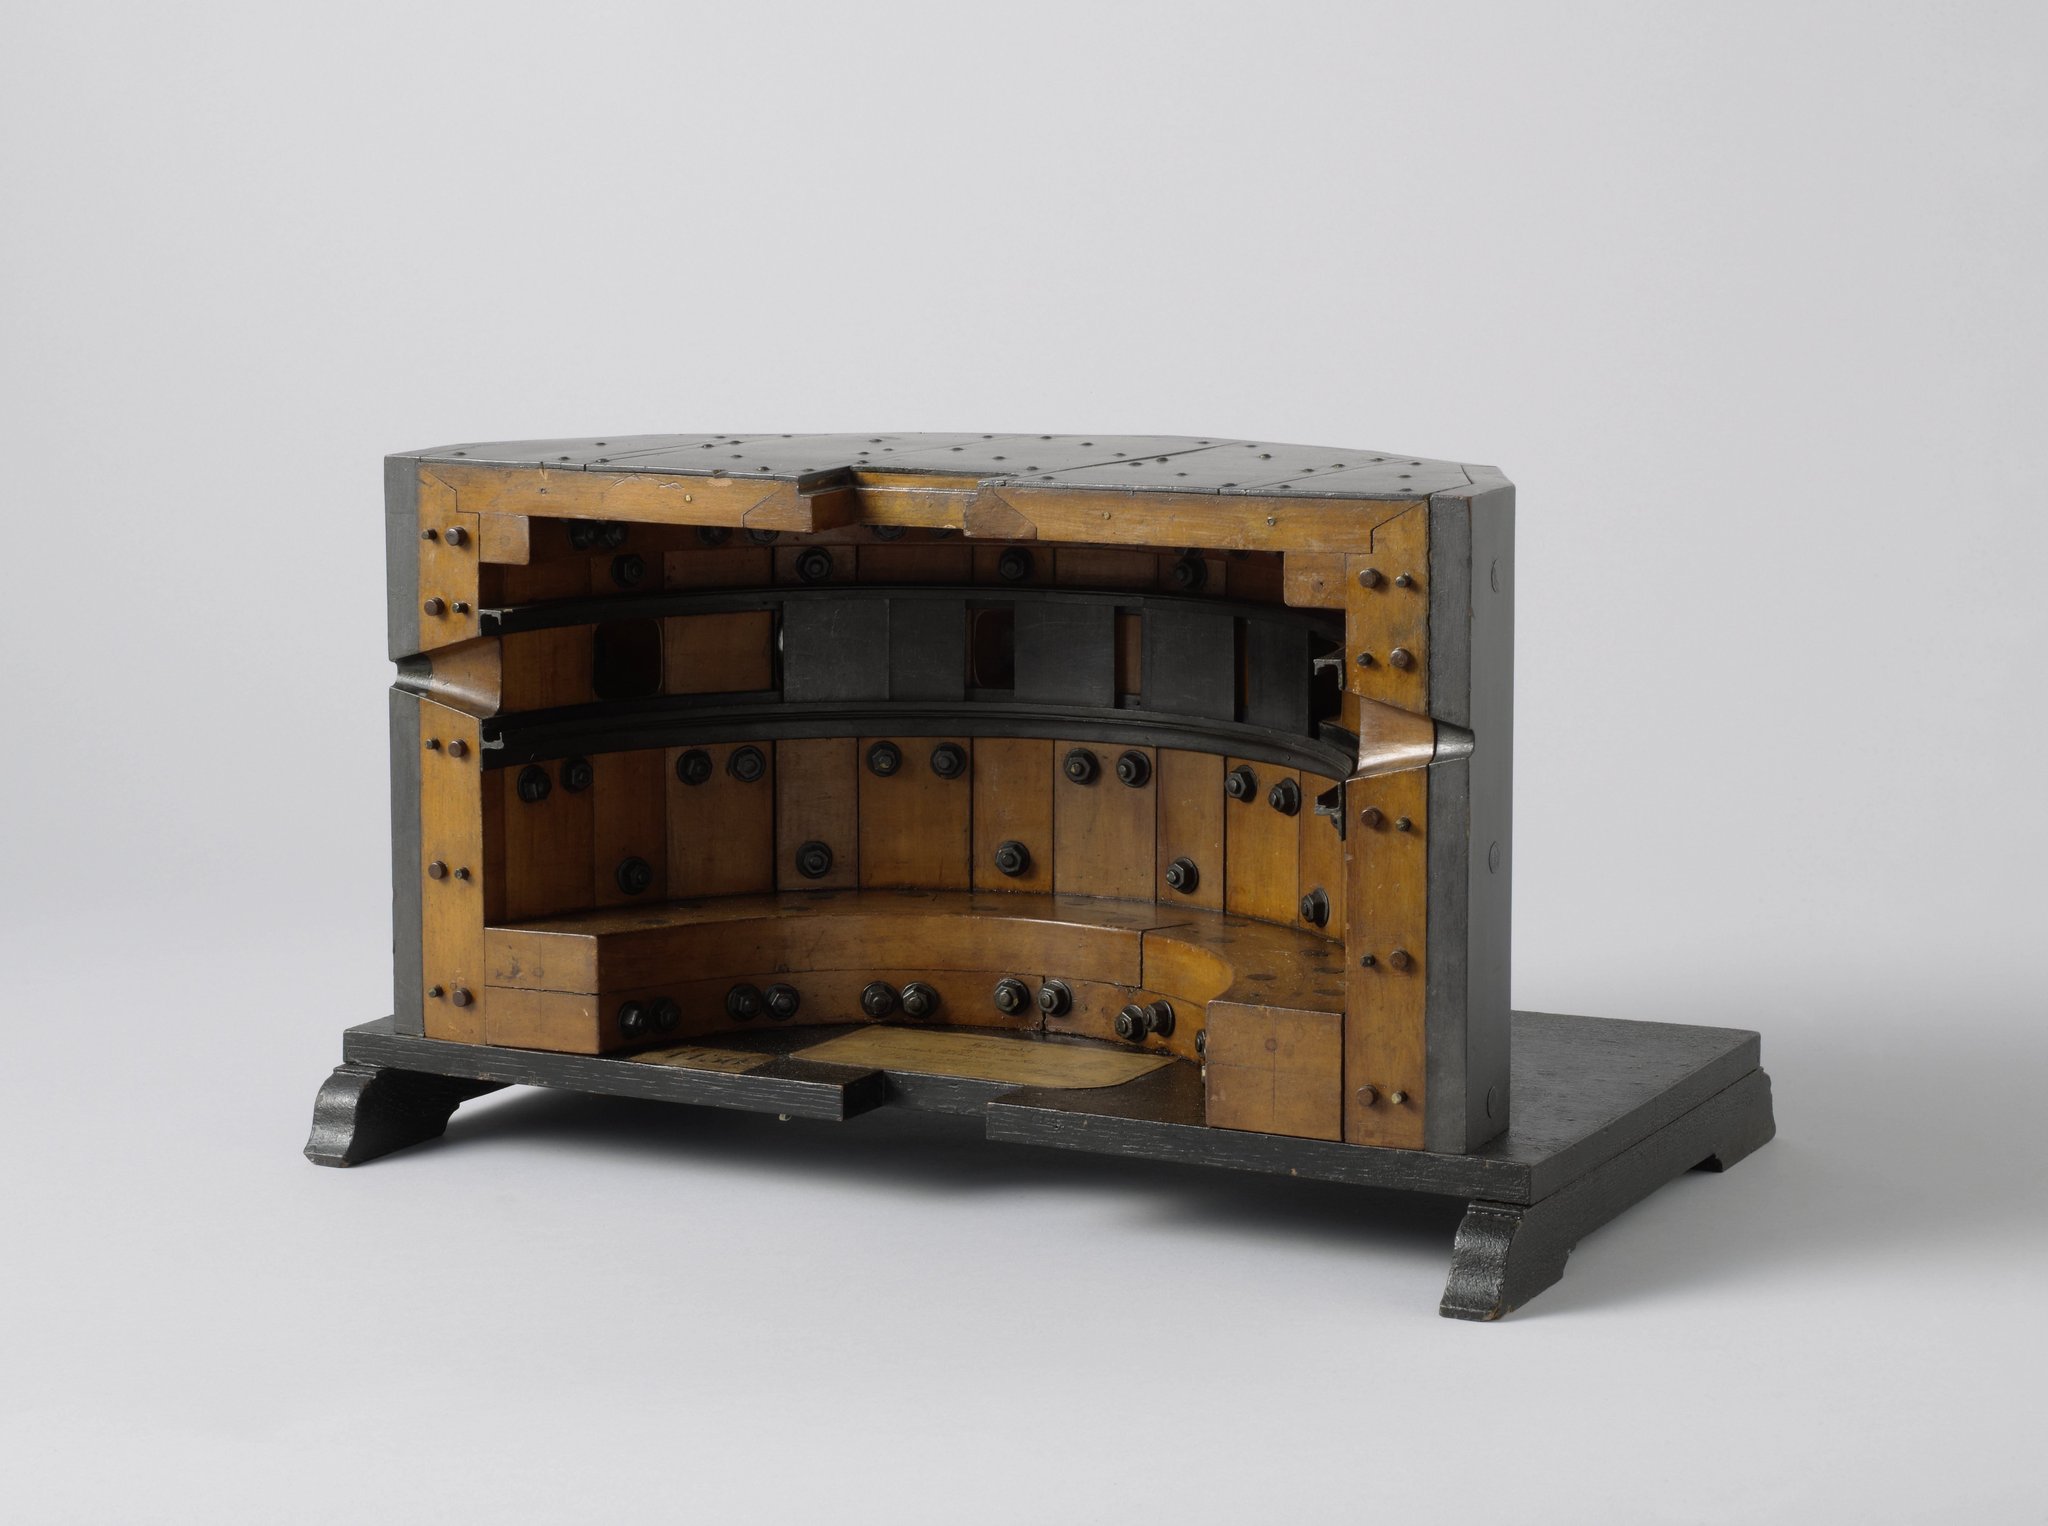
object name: demonstration model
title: Model of a Section of an Armoured Turret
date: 1864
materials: brass, wood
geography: netherlands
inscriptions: inscription, on the base inside the model: ‘halfmodel / van een der beide / Gepantserde blokhuizen voor Scherpschutters / geplaatst op / Z.M. Stoombatterij de Ruyter / op 1/10 der ware grootte.’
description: Halfmodel van een veertienzijdige geschutkoepel, op een grondplank. De buitenschil bestaat uit verticale segmenten, die pantserplaten voorstellen, met een schietgat op driekwart hoogte, dat naar binnen toe wijder wordt. De binnenwand is van hout en heeft een cirkelvormige binnendiameter. Binnen kunnen de schietgaten worden afgesloten met pantserplaten, die tussen rails tegen de wand heen en weer worden geschoven. Zware houten balken verstevigen de onder- en bovenkant van de toren rondom. Het model laat alle bouten zien, die dwars door pantserplaten en binnenwand lopen. Schaal 1:10 (schaal op model).